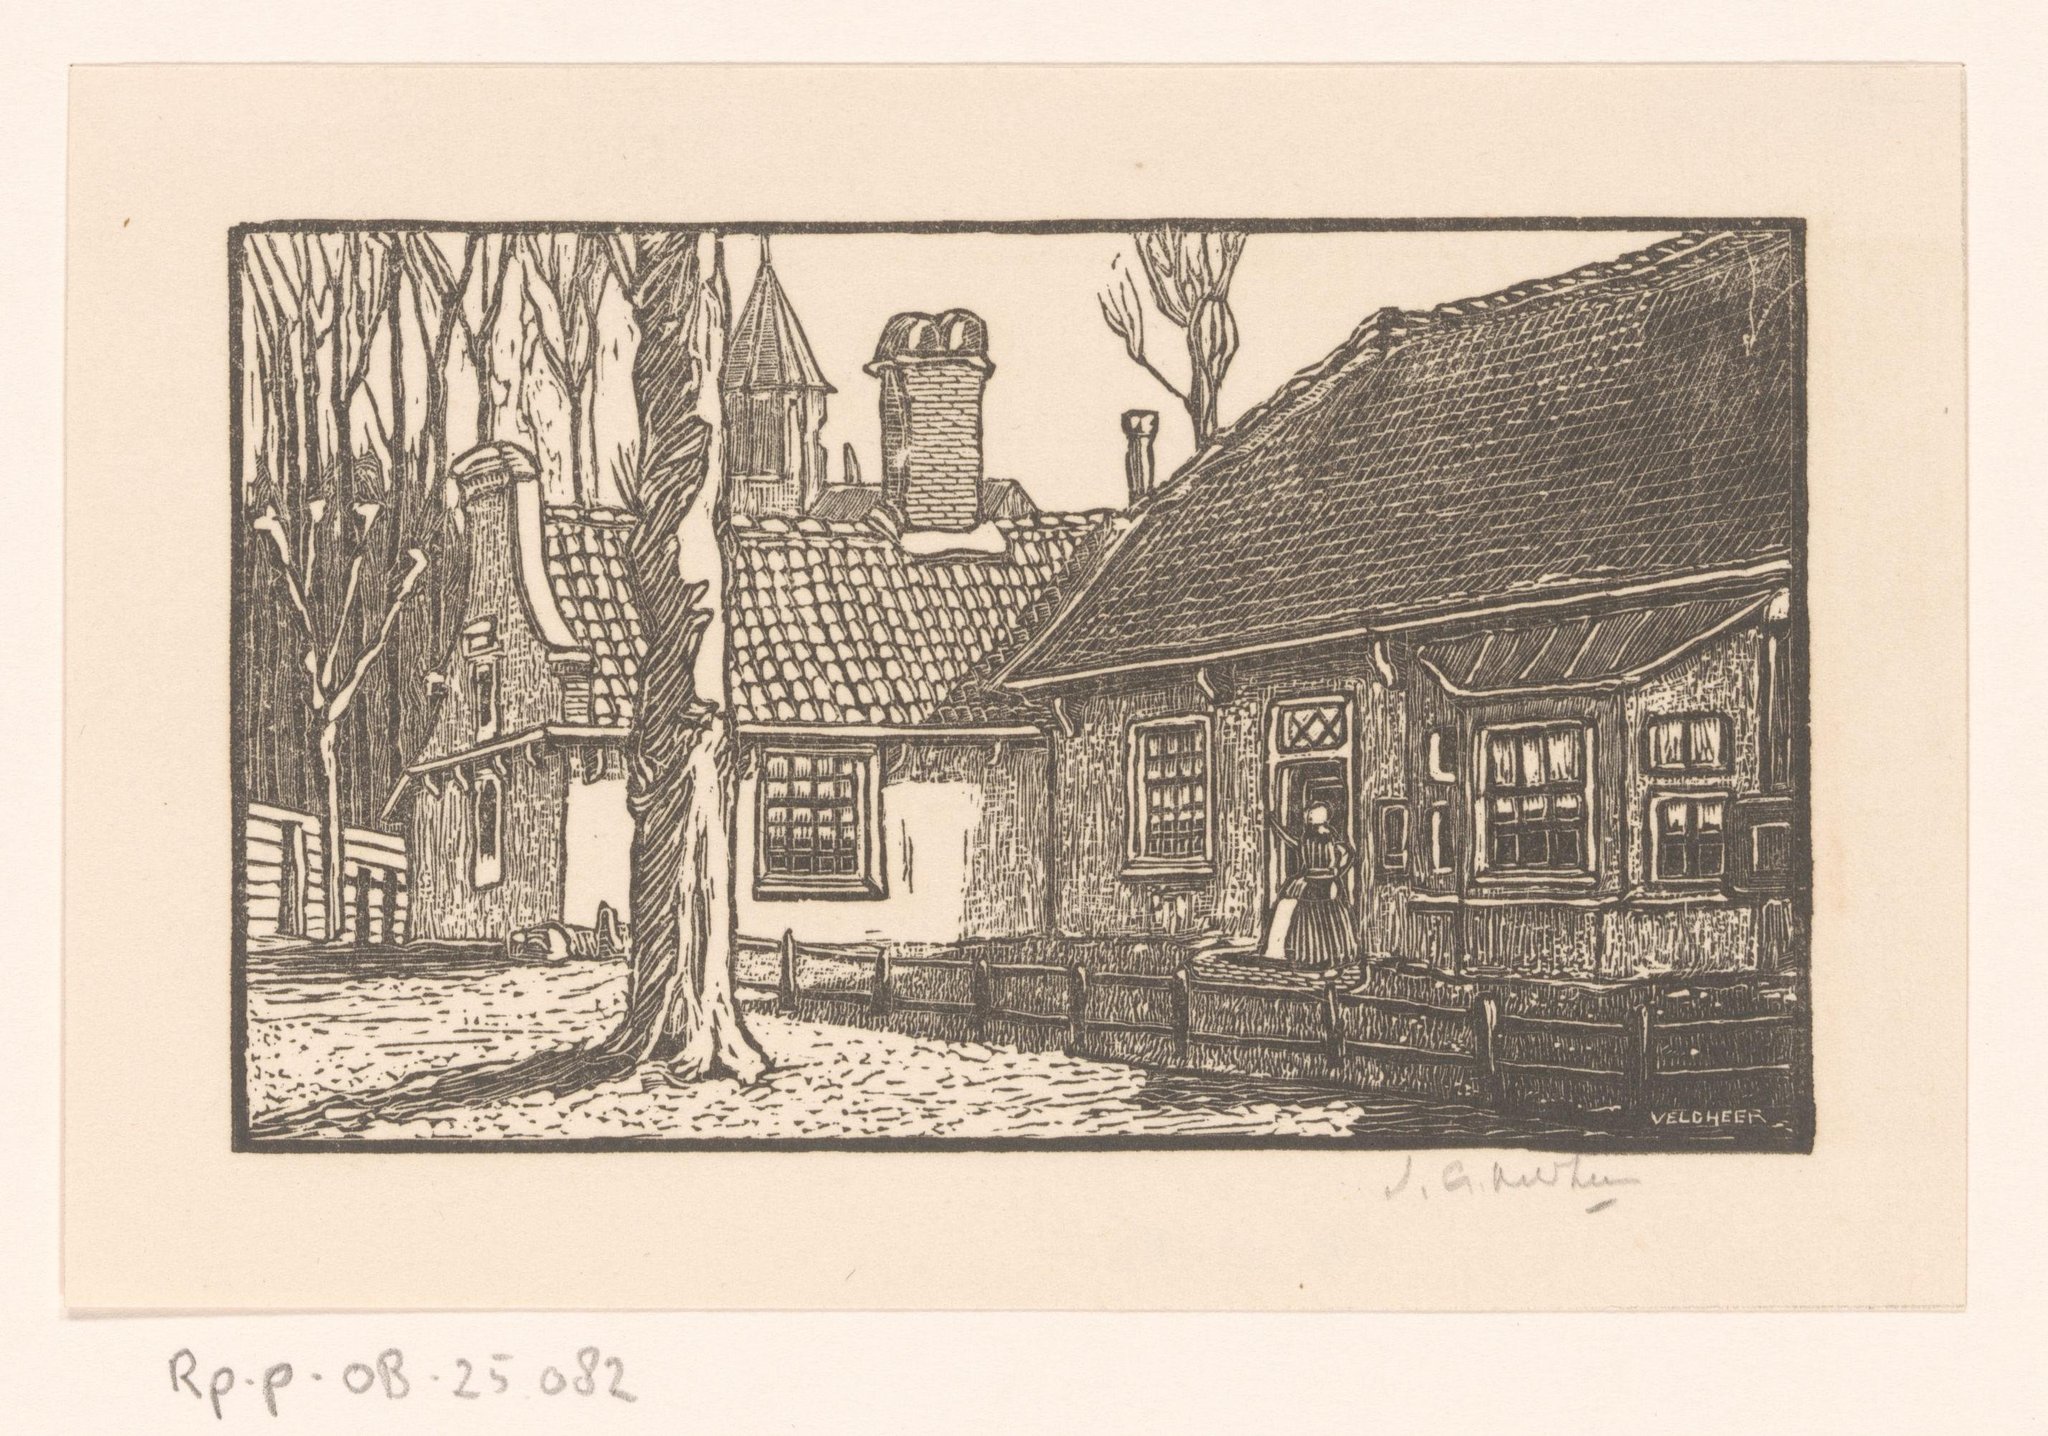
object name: print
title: In het dorp Bergen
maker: jacobus gerardus veldheer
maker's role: draughtsman, print maker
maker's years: 1866-1954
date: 1876-1954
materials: paper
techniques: woodcut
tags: village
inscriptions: annotation: ‘In het dorp Bergen/ [...] eigen pers op Hollandsch/ deze houtsnede is uitsluitend/ proef [...]/ J.G. Velheer’, collector's mark: Lugt 2228